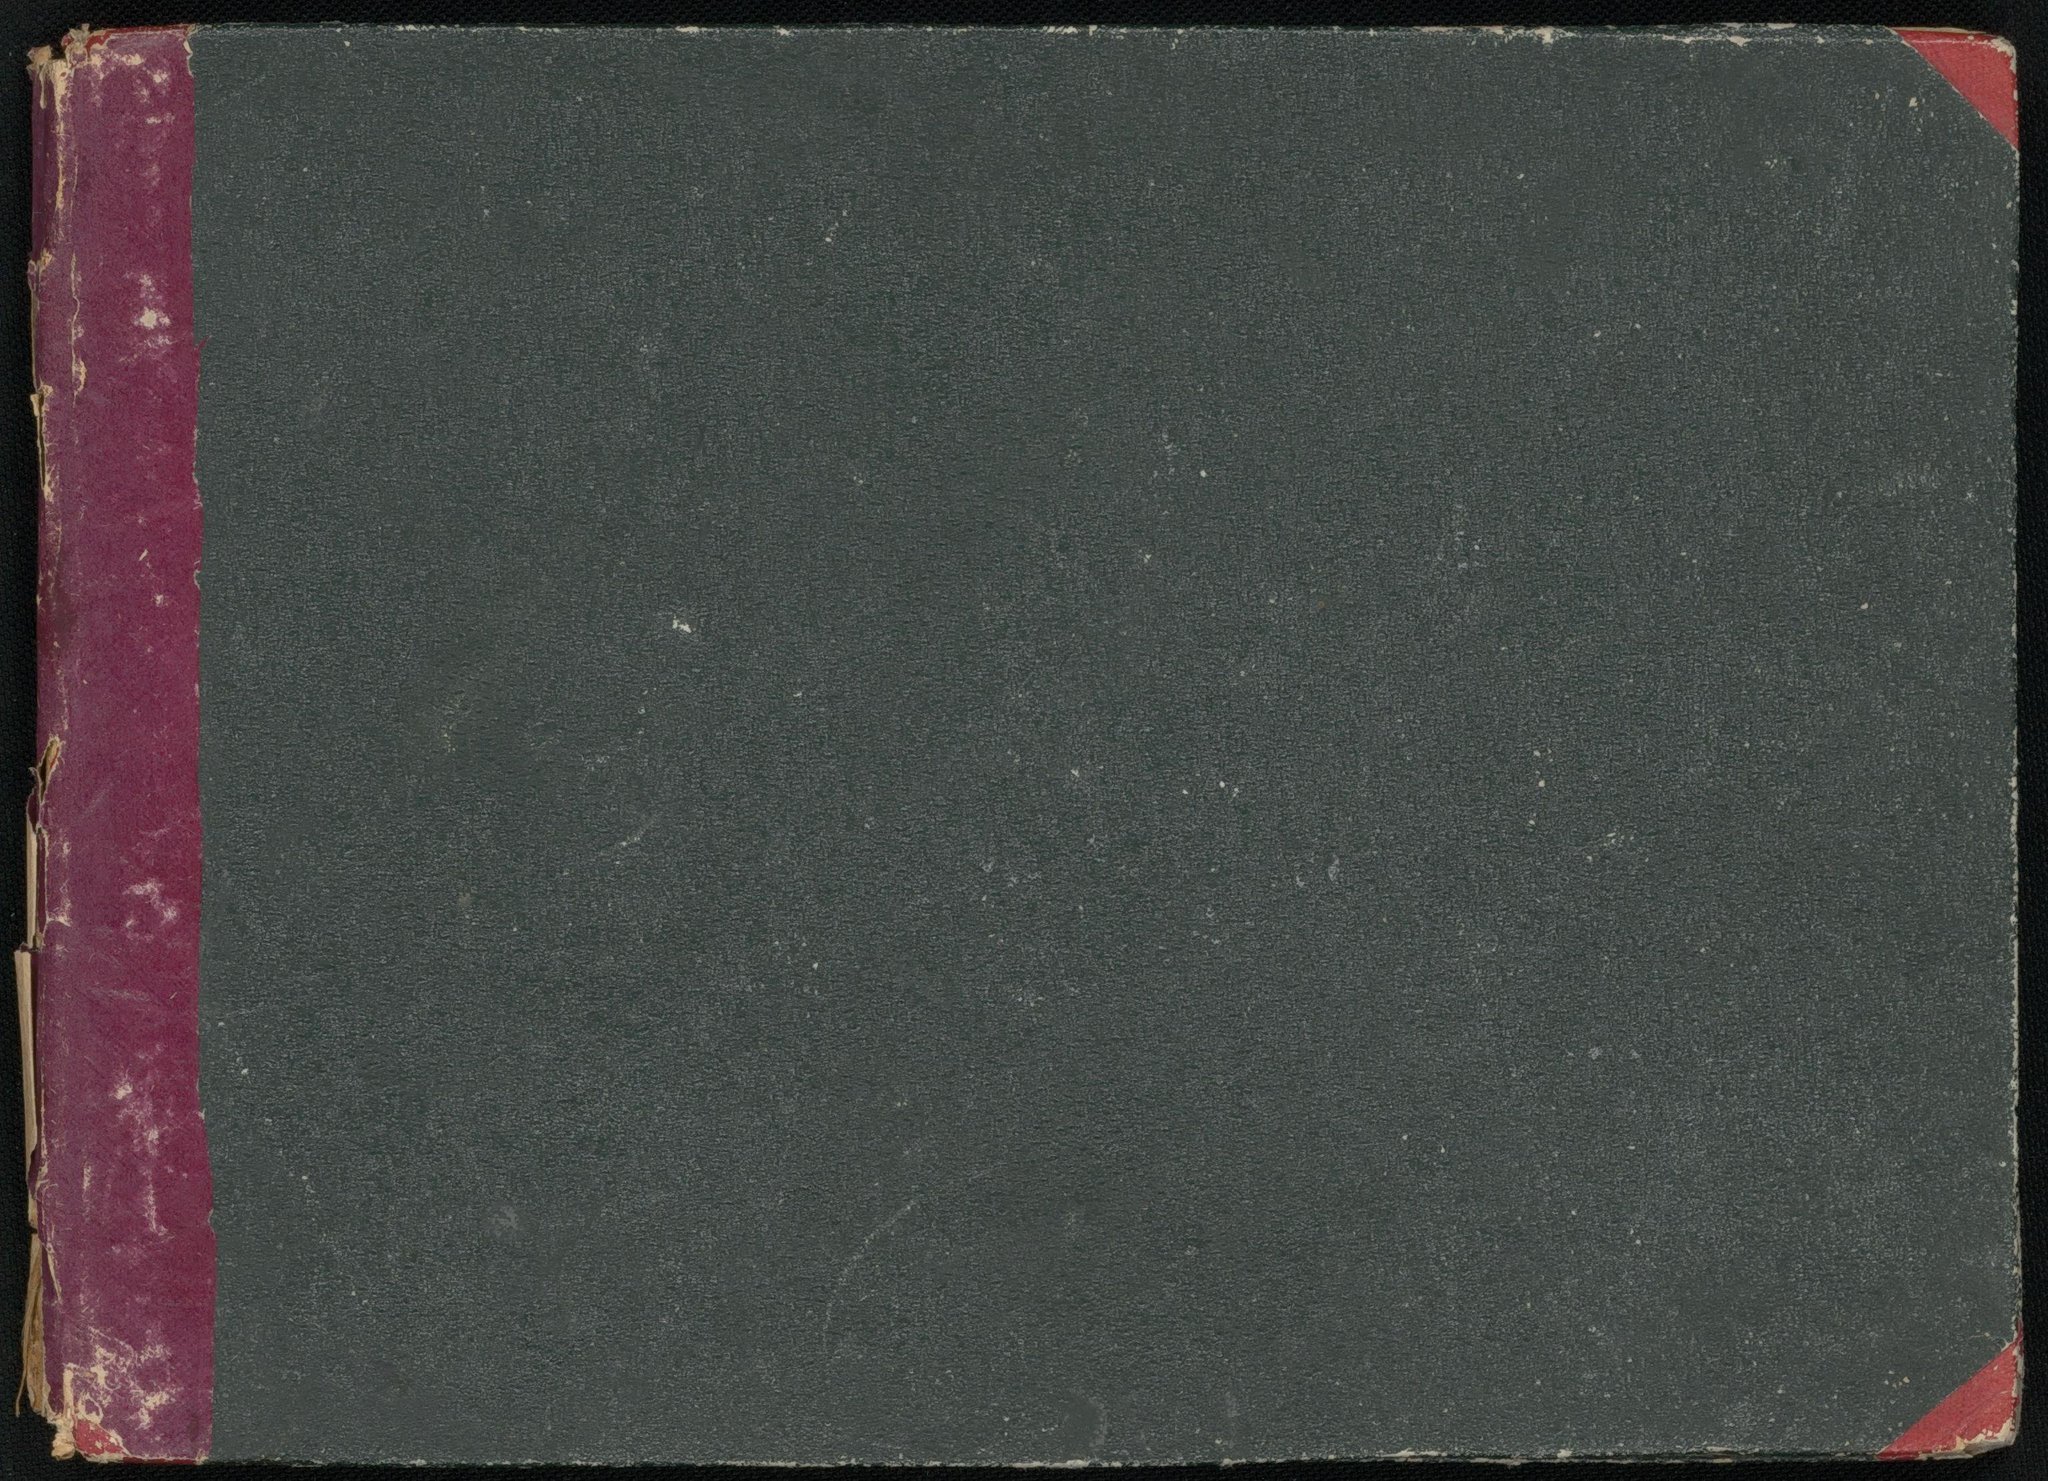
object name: scrapbook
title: Album gevuld met plakplaatjes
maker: Anonymous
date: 1880-1910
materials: cardboard, paper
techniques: chromolithography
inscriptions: collector's mark: ‘Bibliotheek Koninklijk Oudheidkundig Genootschap Amsterdam / 1972-1974:2’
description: Album met 38 bladen gevuld met plakplaatjes, poesieplaatjes en uitgeknipte en ingeplakte fragmenten van prenten. Ingebonden in harde omslag met rode rug en hoeken en boekplaten bekleed met grijsgroen papier. Schutbladen van geel papier. Voorin twee legen bladen. Een deel van de bladen is er uitgesneden. Onderwerpsrubrieken binnen de Atlas Zeden en Gewoonten: Schoone kunsten, Varia.